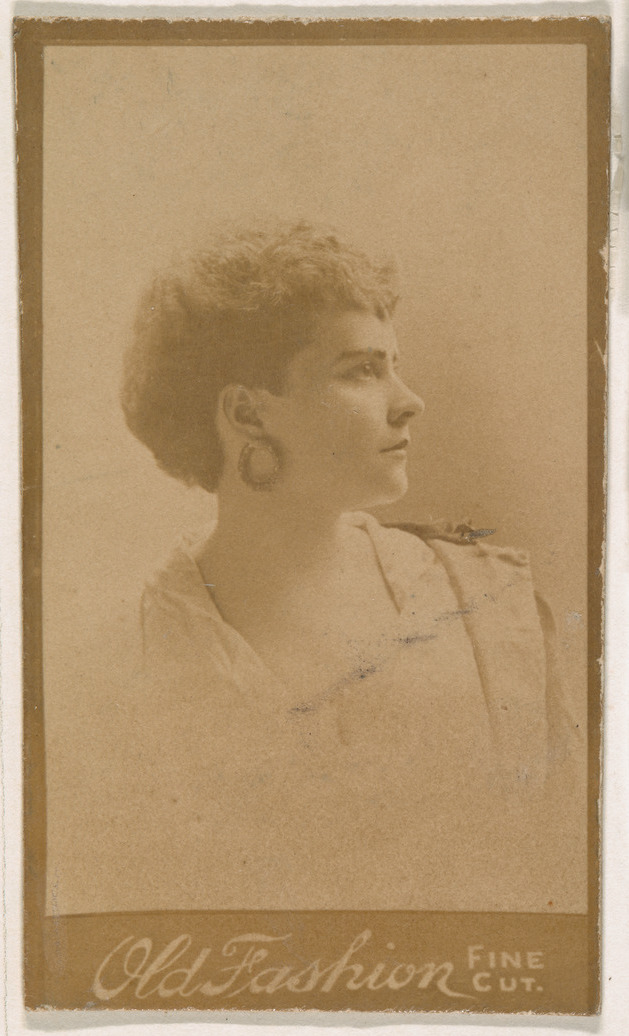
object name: photograph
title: Actress wearing hoop earrings, from the Actresses series (N664) promoting Old Fashion Fine Cut Tobacco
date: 1888-1890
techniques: albumen silver print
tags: portraits,women,actresses